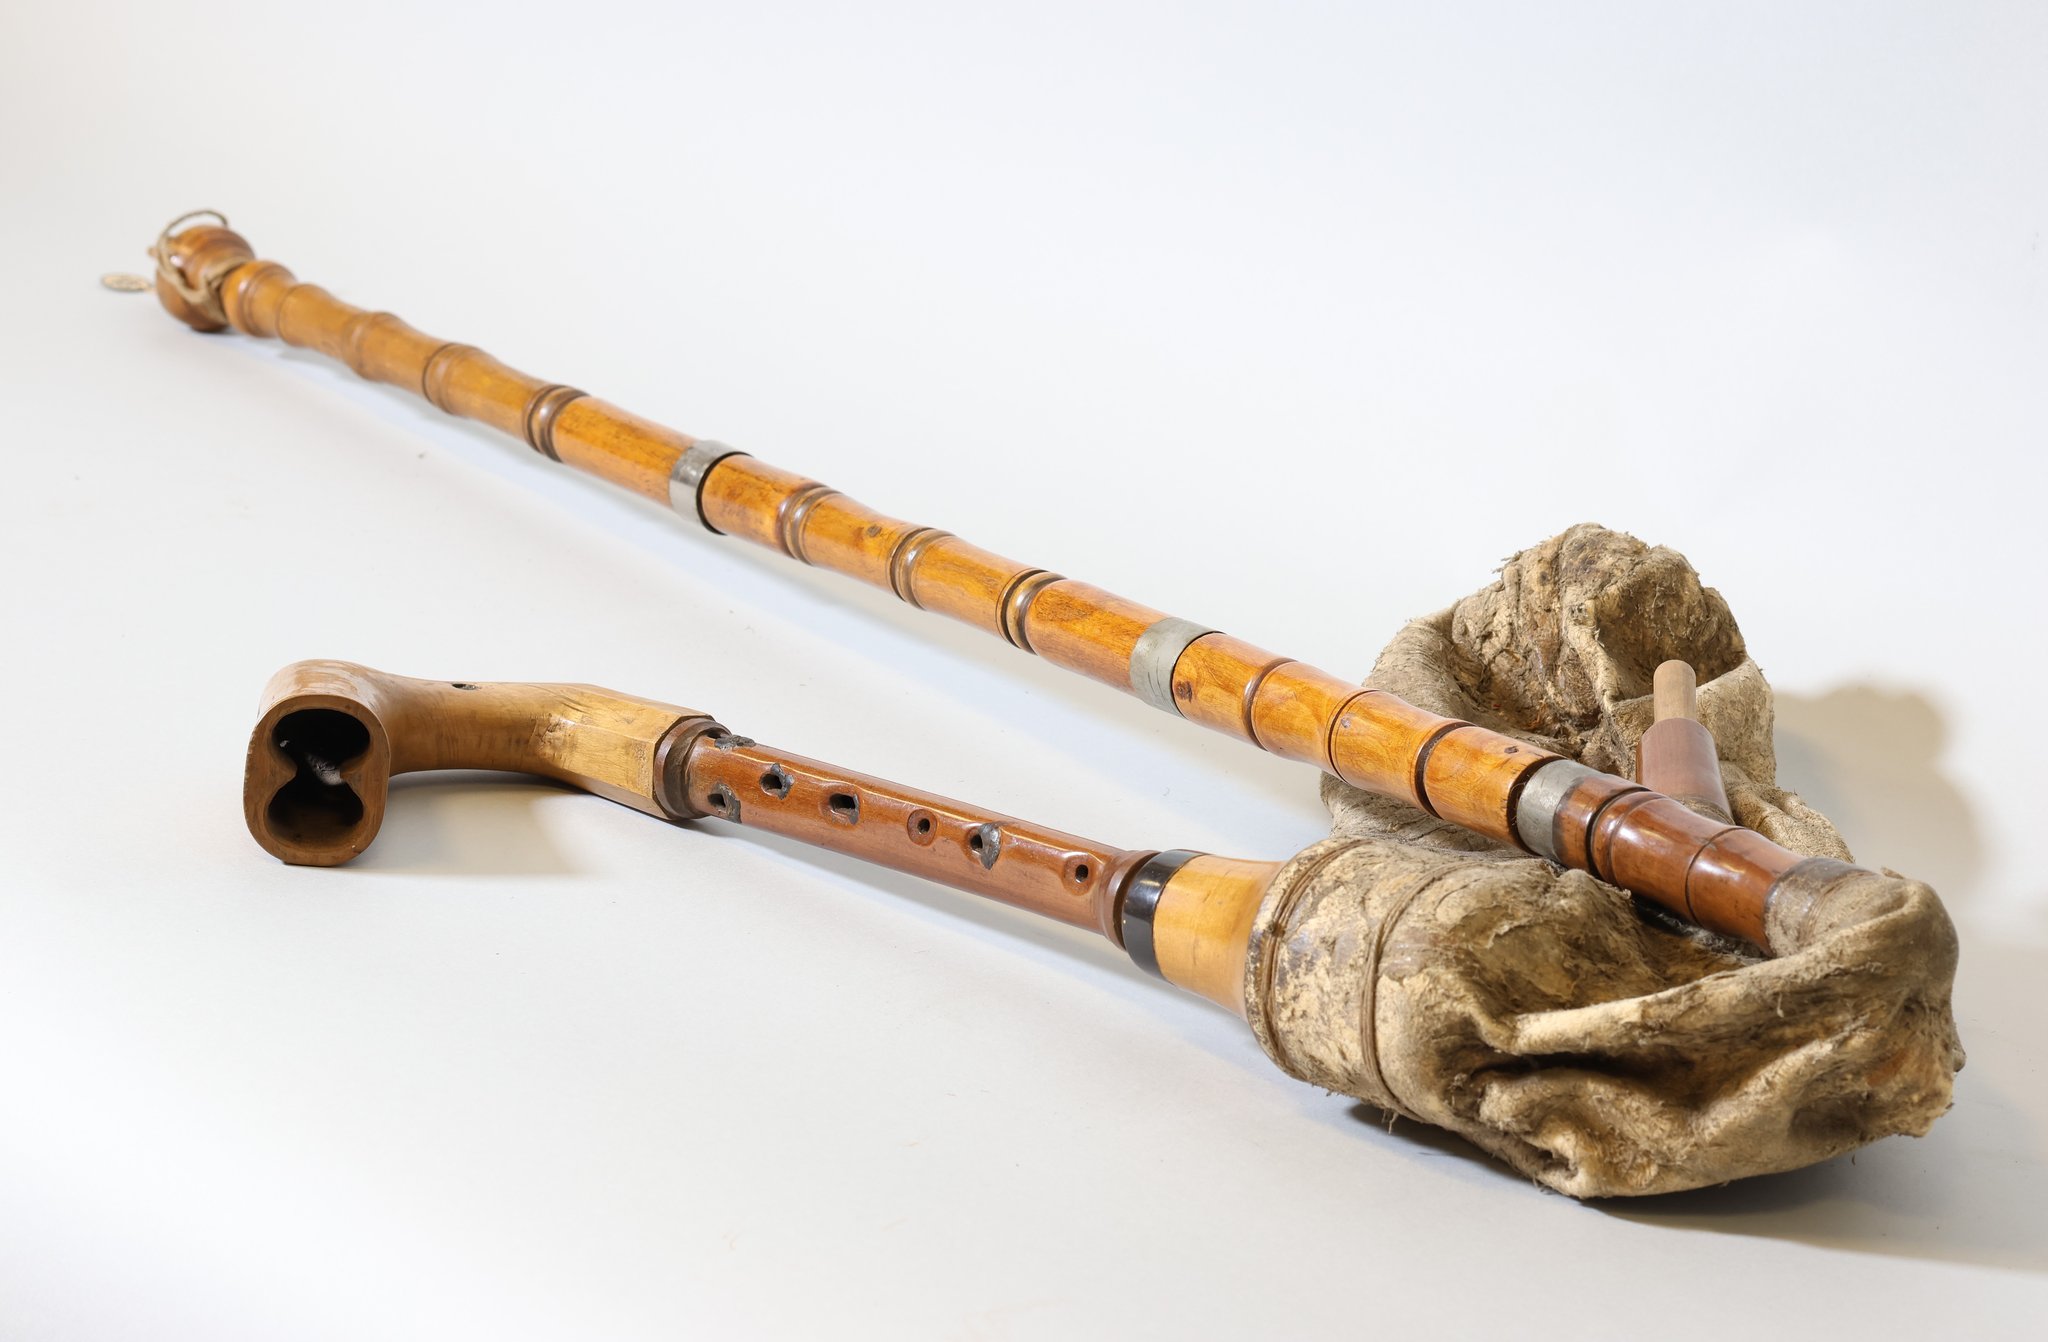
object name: gajde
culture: croatian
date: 1867-1900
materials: leather, horn, nickel, silver, wood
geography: croatia